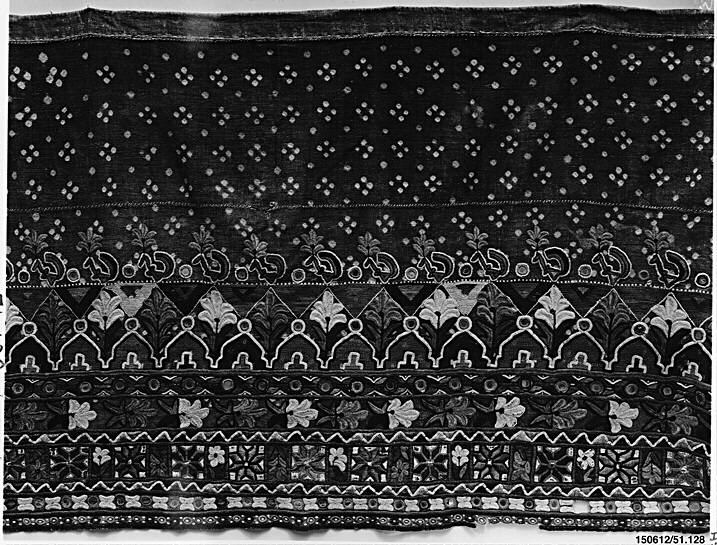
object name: valance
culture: indian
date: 1801-1900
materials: cotton, linen